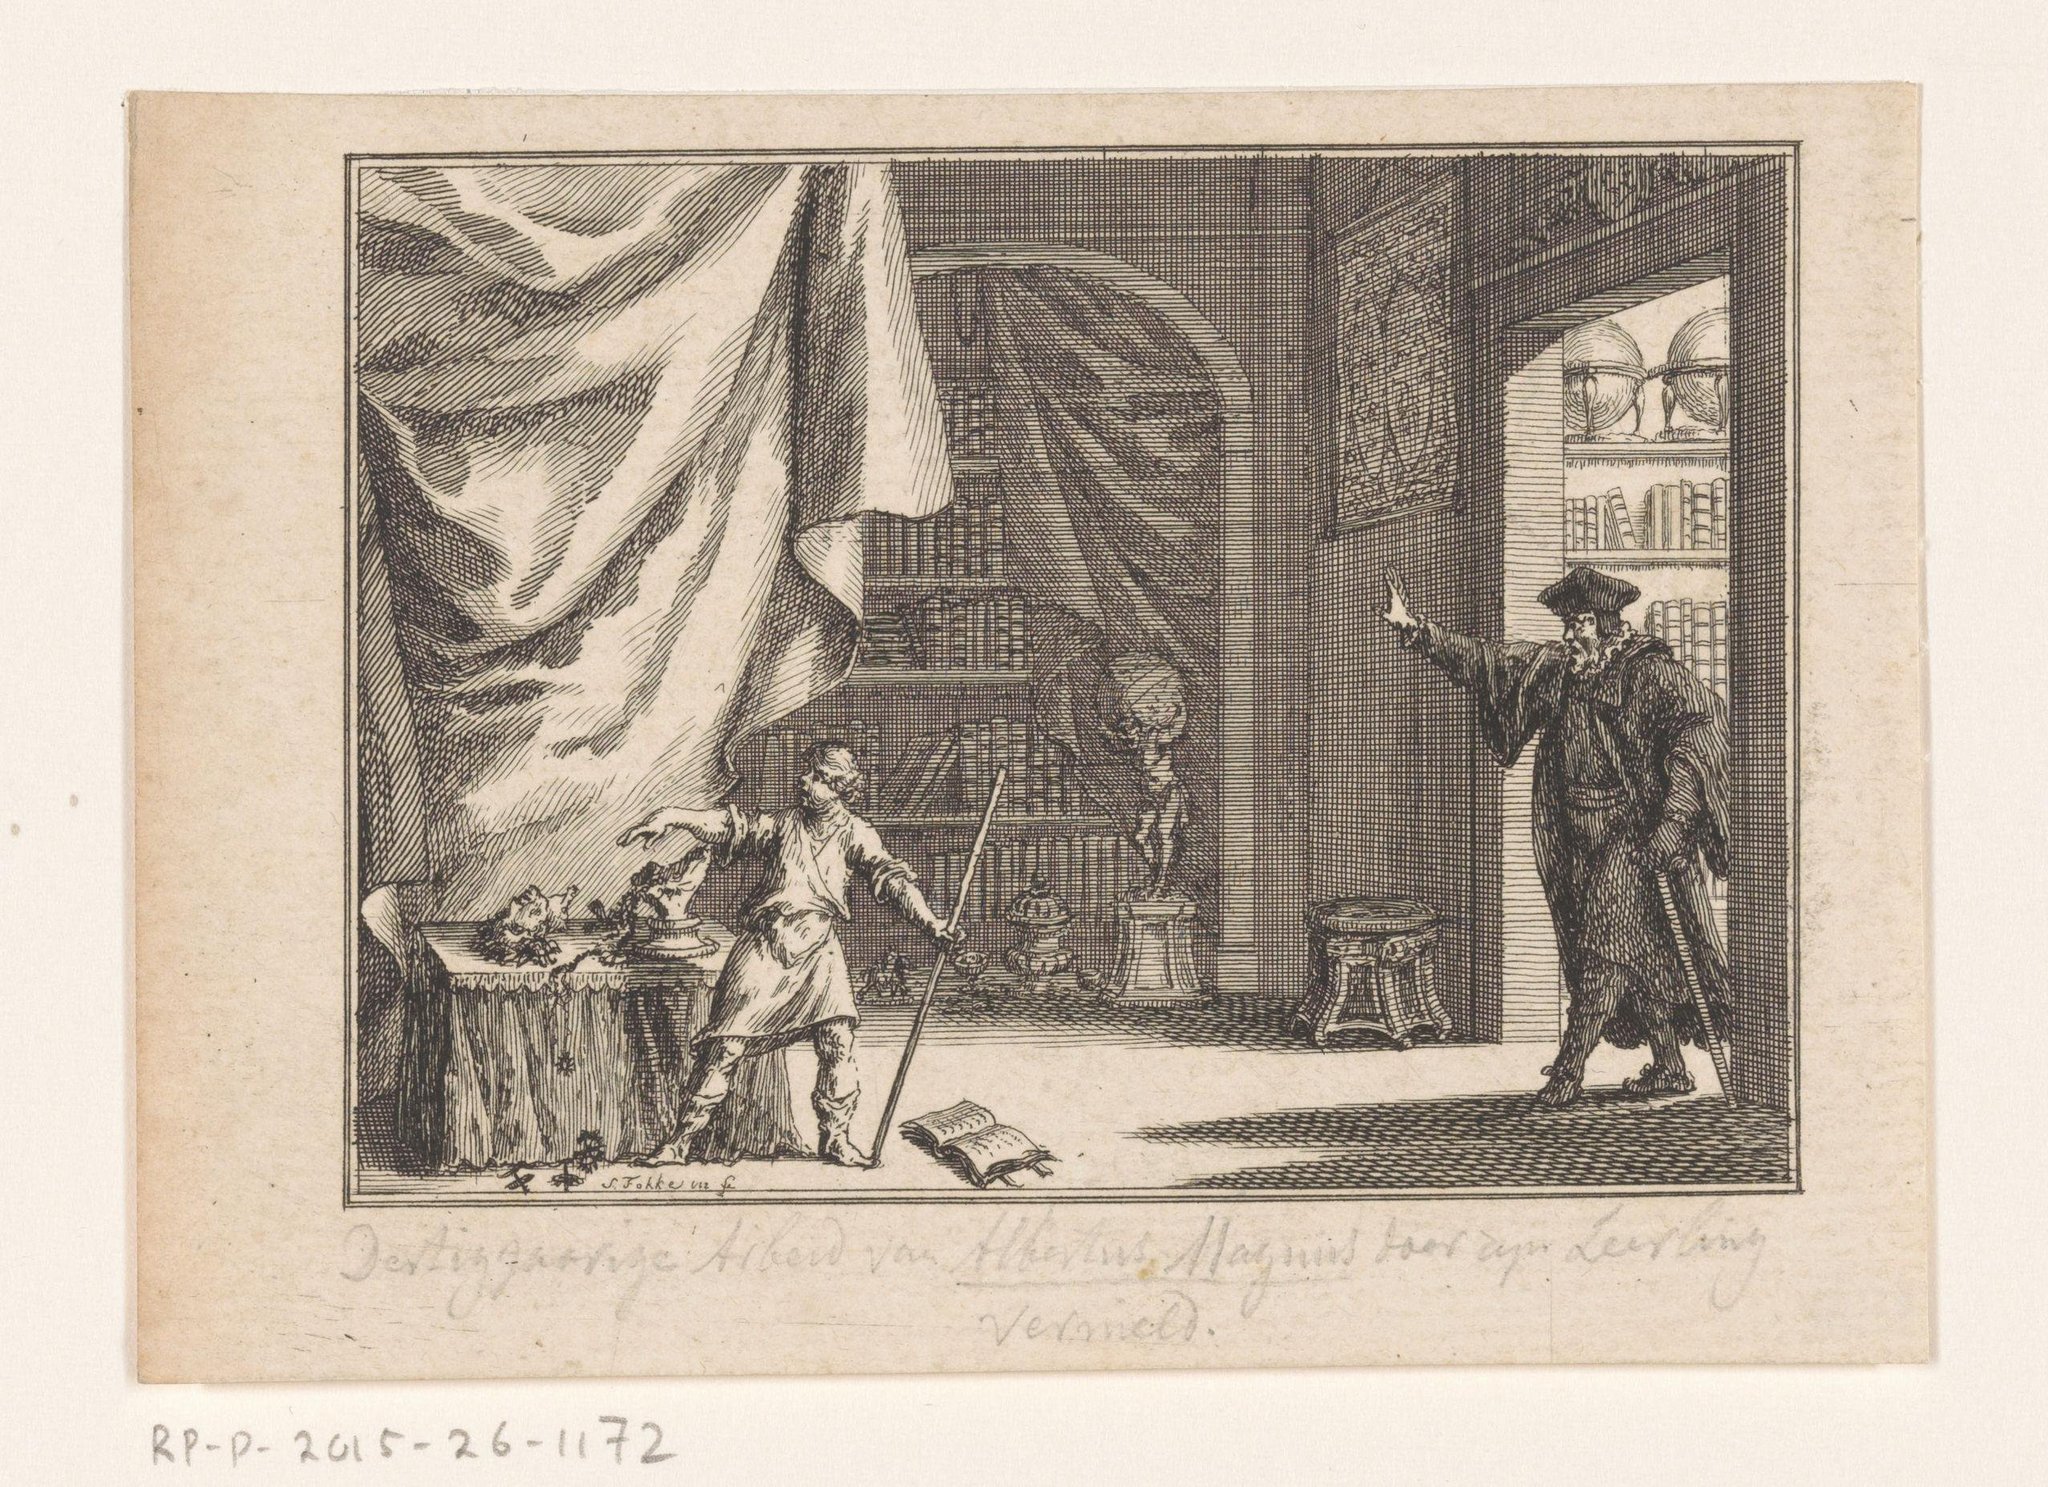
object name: print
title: Thomas van Aquino vernielt het pratende beeld van Albertus Magnus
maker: simon fokke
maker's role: draughtsman, print maker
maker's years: 1712-1784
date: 1722-1784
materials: paper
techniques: etching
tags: thomas van aquino, cologne, albertus magnus, destruction, automaton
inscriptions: collector's mark: Lugt 4779, annotation: ‘dertigjaarige arbeid van Albertus Magnus door zijn leerling vernield’, collector's mark: Lugt 2228, collector's mark: Lugt 4780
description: Volgens de overlevering zou Albertus Magnus een pratend beeld hebben gemaakt dat zou zijn vernield door zijn leerling, Thomas van Aquino. Rechts komt Albertus Magnus zijn studeerkamer uit, links staat Thomas van Aquino met een stok in zijn hand naast de resten van het beeld.